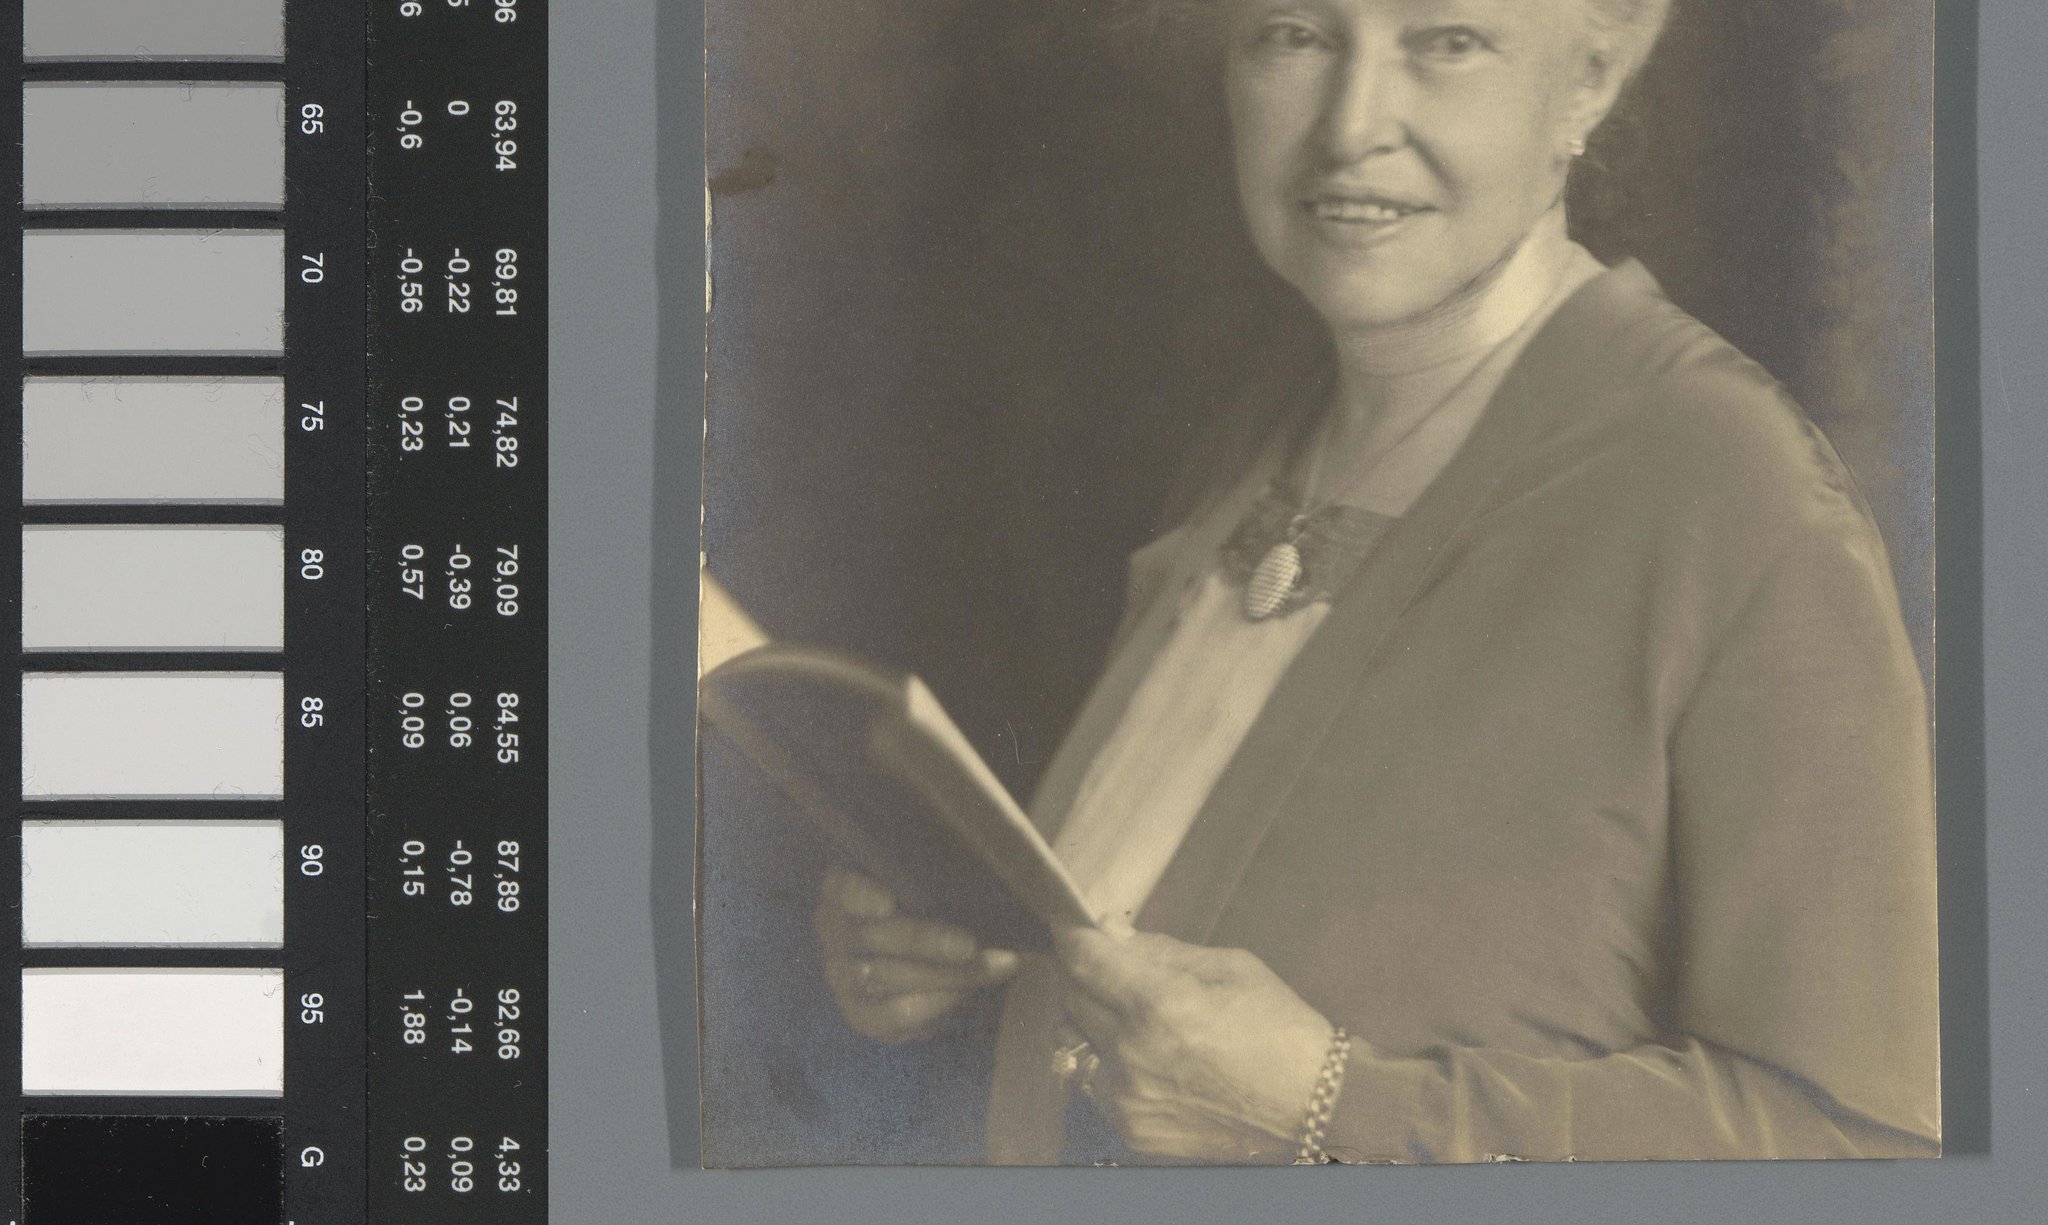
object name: photograph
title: Portret van Sophia Wilhelmina van Taack Tra Kranen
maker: Anonymous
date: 1882-1920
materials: photographic support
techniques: photography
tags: batavia, historical persons - bb - woman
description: Portret van Sophia Wilhelmina van Taack Tra Kranen, echtgenote van jhr. Frederik Teding van Berkhout, met een boek in de handen.